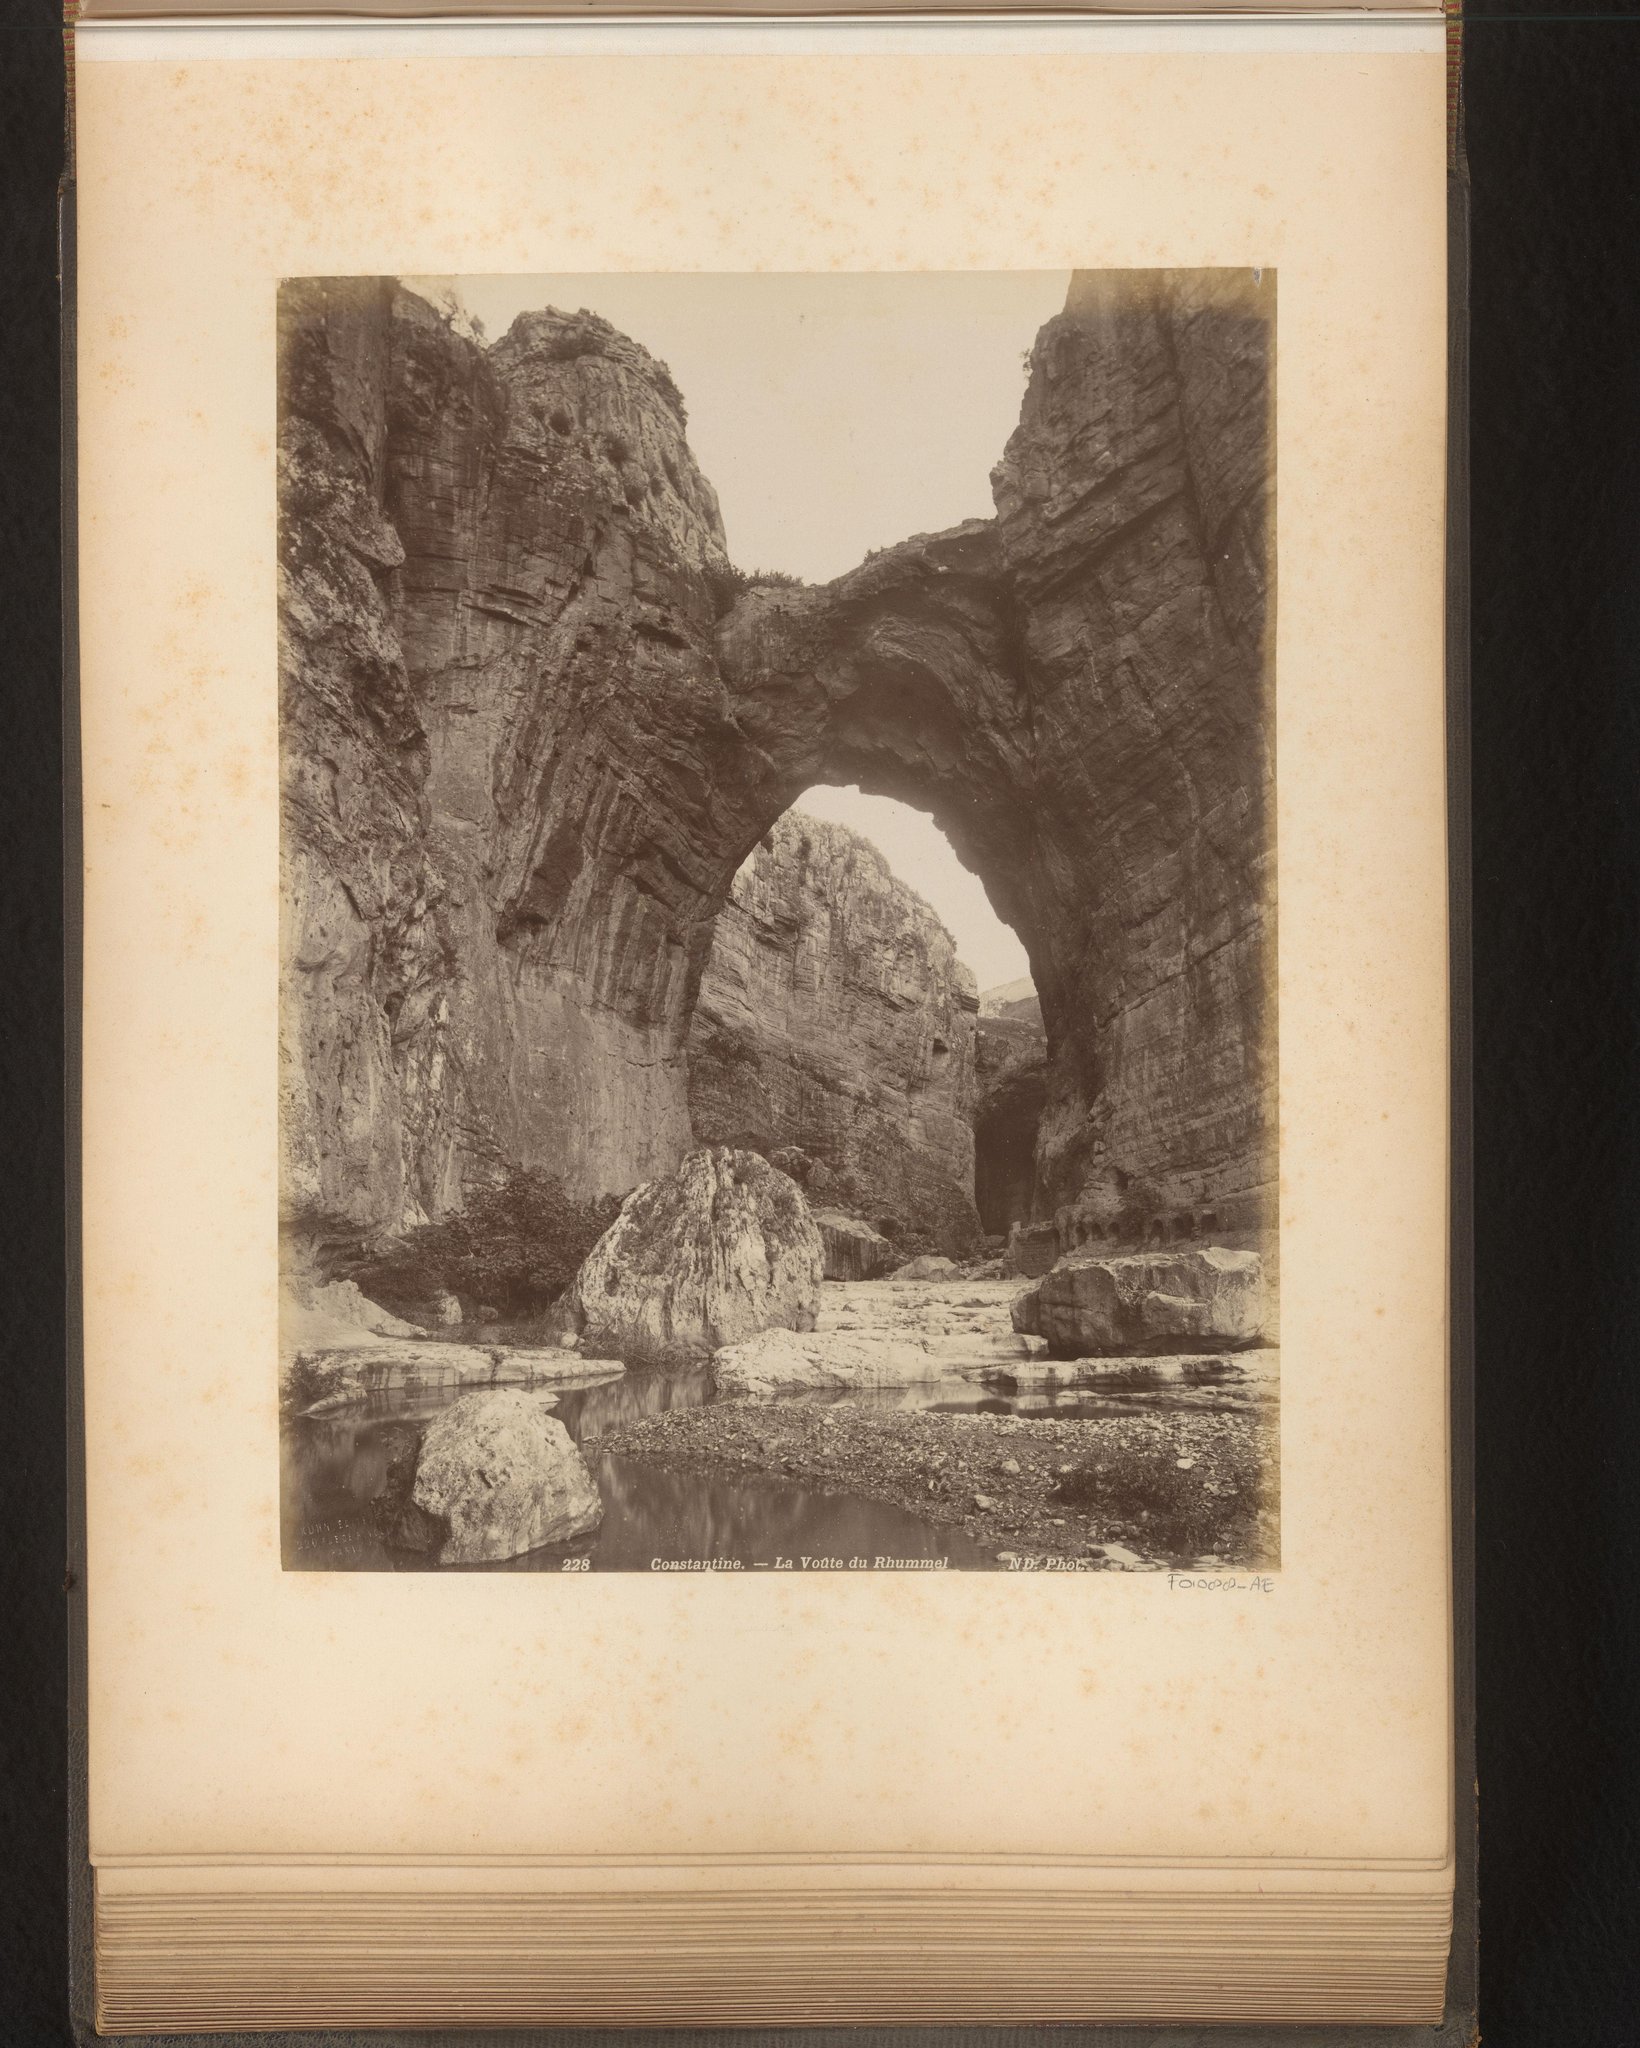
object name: photograph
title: Constantine. - La Voute du Rhummel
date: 1880-1890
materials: photographic support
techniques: albumen print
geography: algeria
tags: water course, rocks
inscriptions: check stamp: ‘J. Kuhn Editeur/ 220 Rue de Rivoli Paris’, number: ‘228’